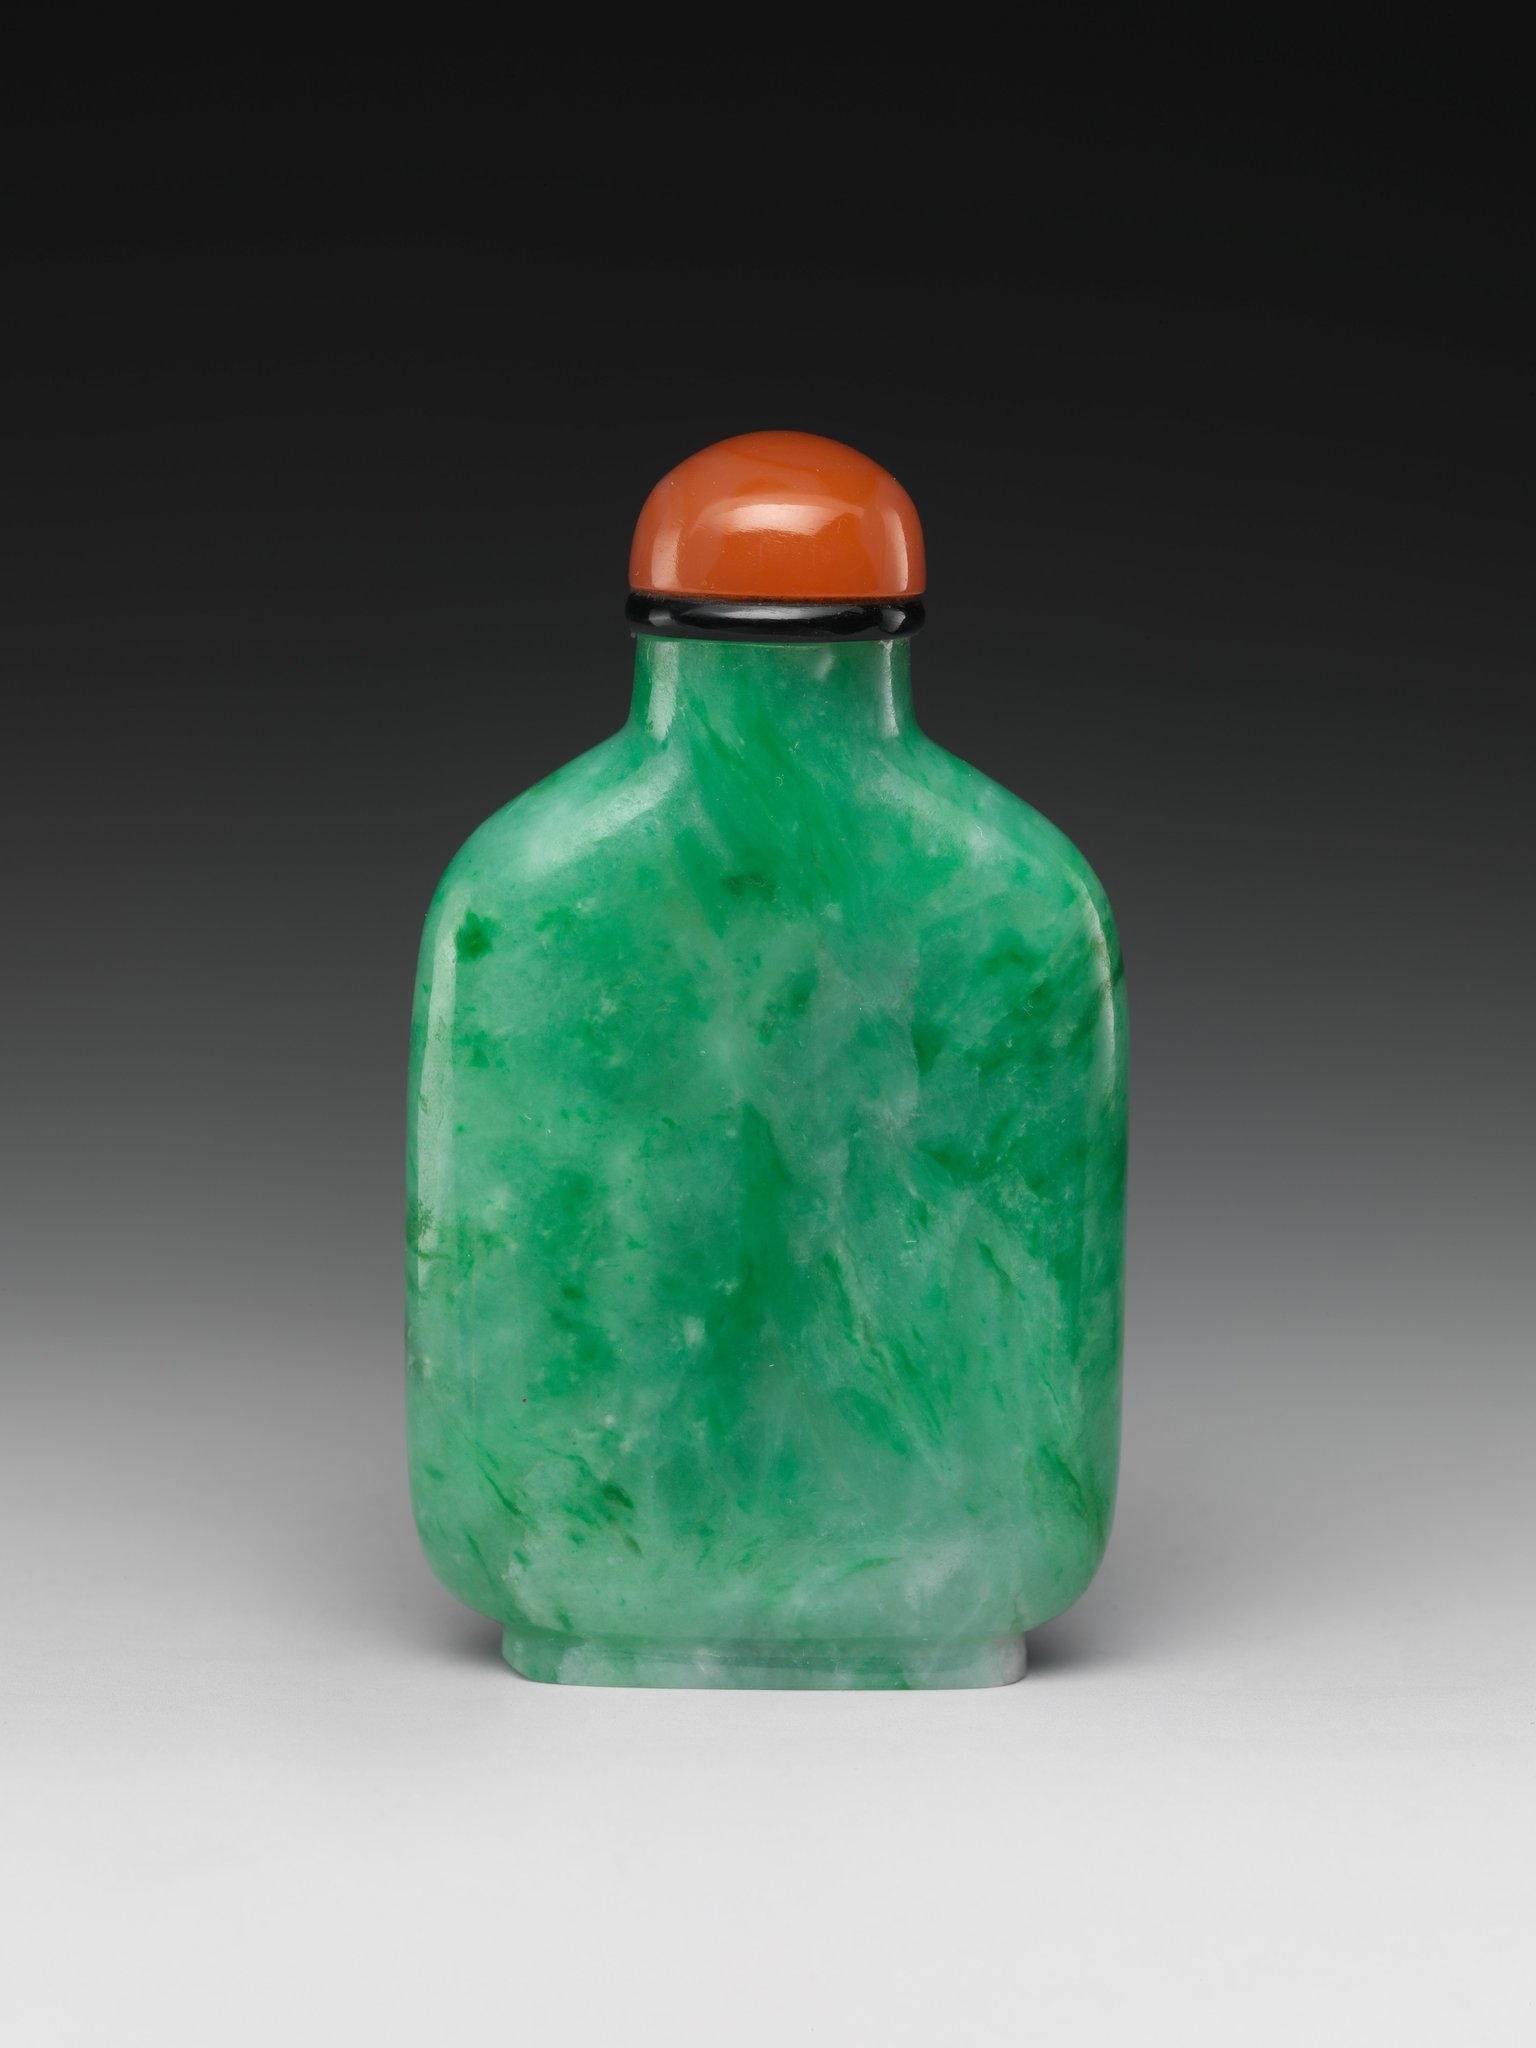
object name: snuff bottle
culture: chinese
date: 1767-1800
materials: stone, jade